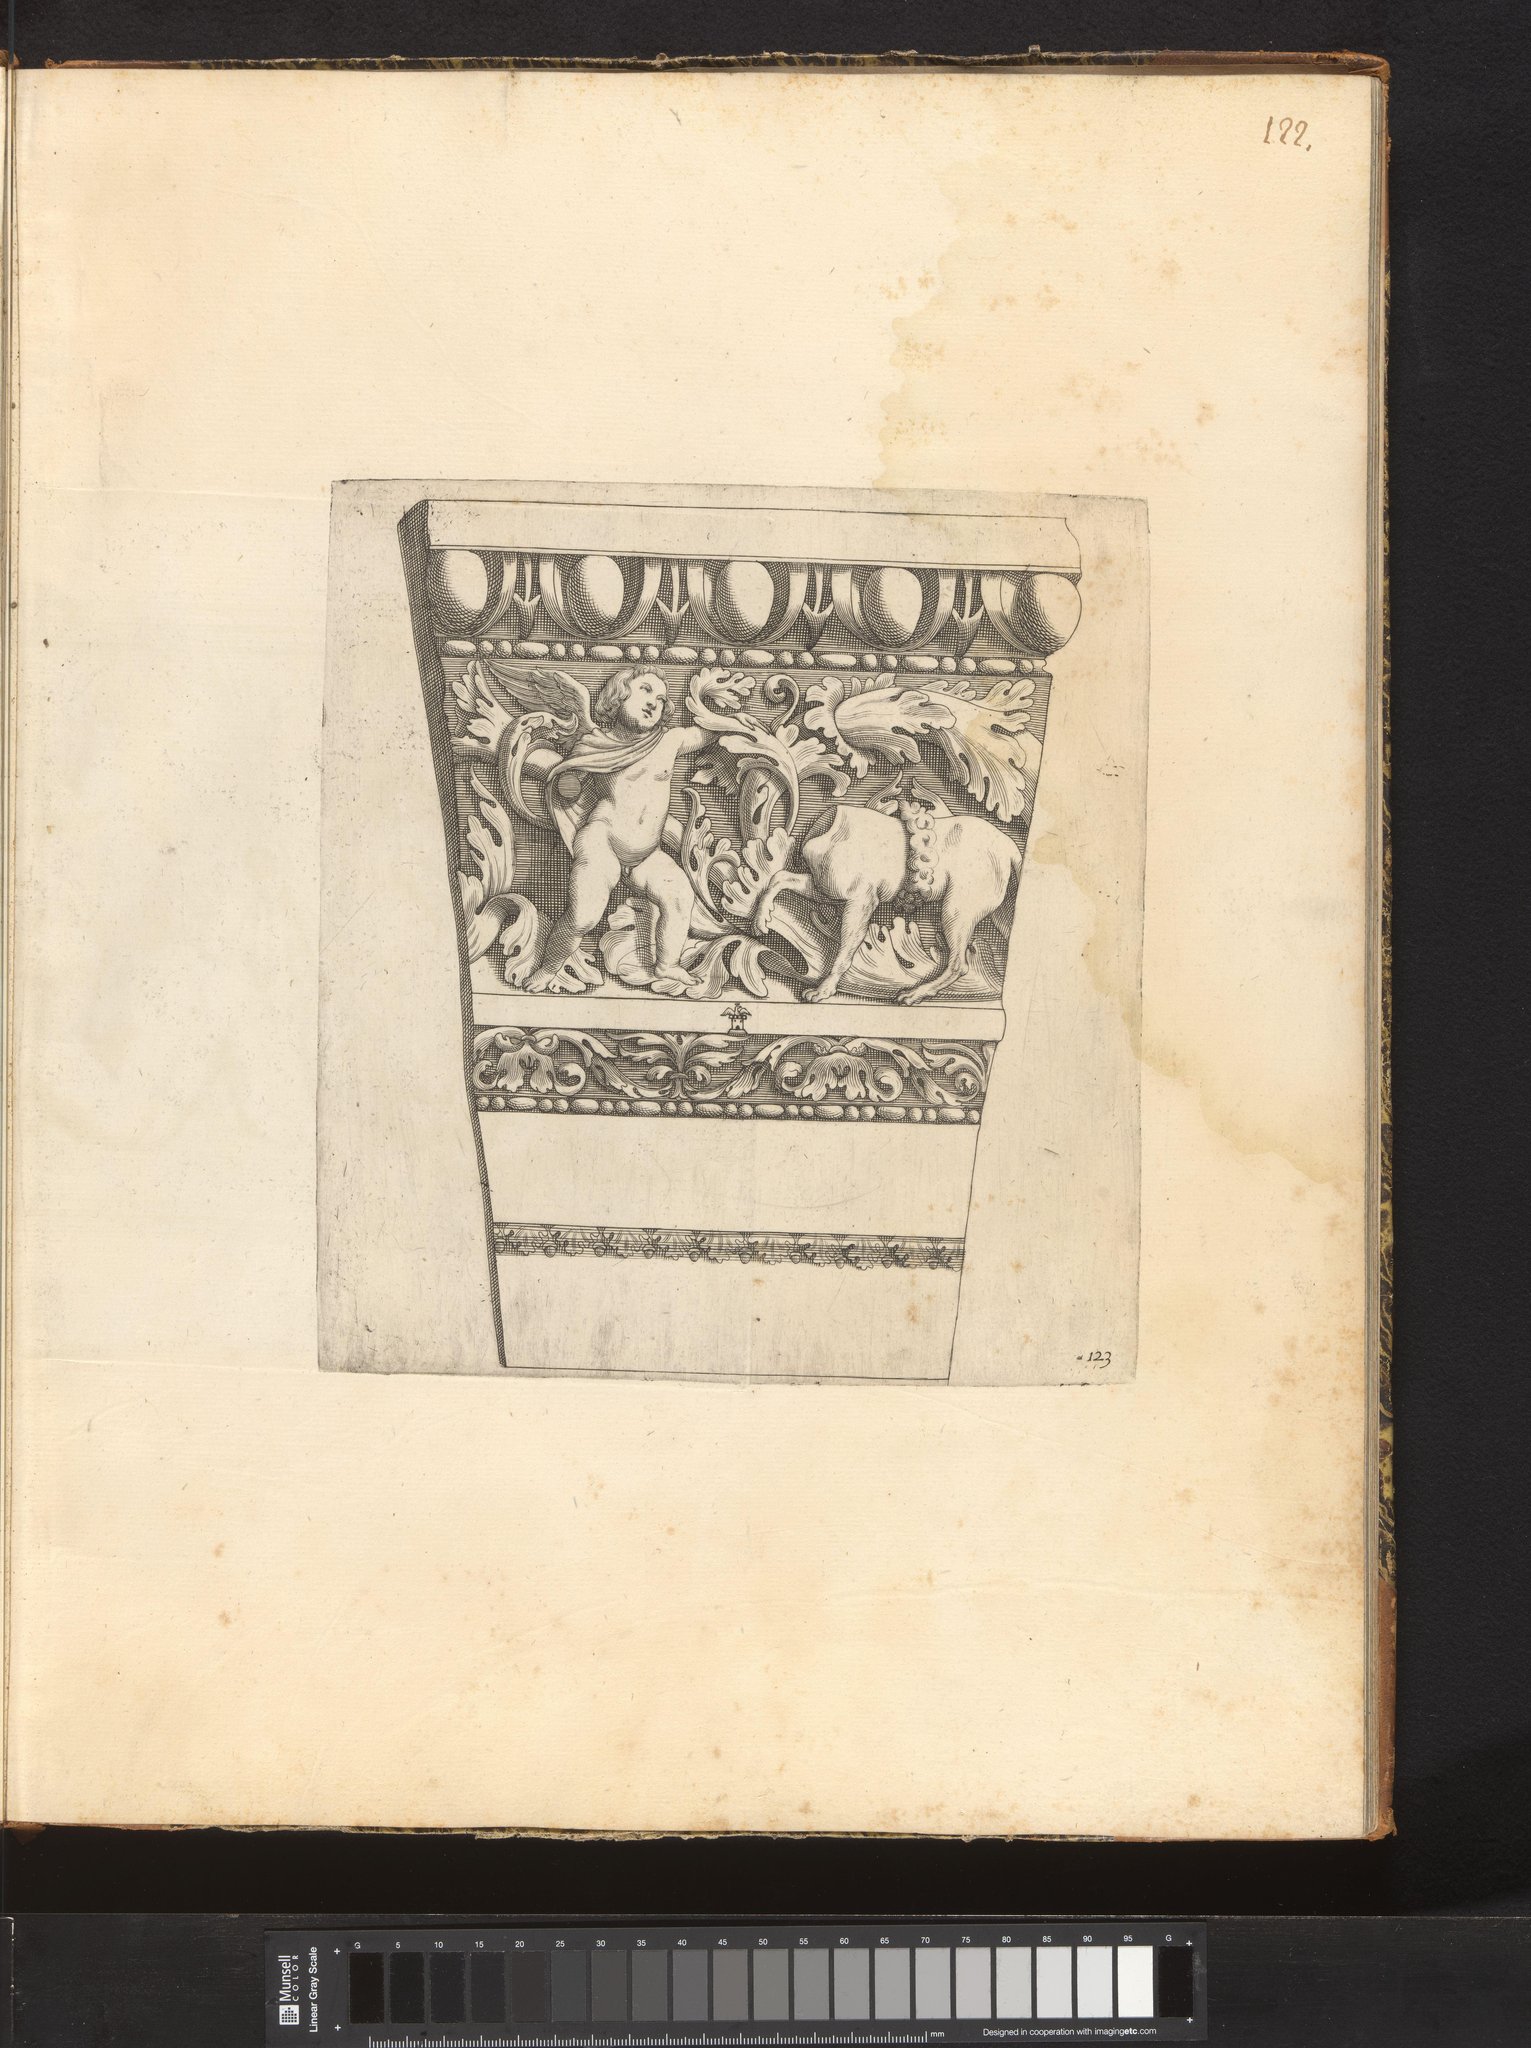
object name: print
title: Galleria Giustiniana del Marchese Vincenzo Giustiniani II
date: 1636-1647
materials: paper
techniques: engraving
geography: rome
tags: (story of) proserpina (persephone, core), libera, column, pillar ~ architecture, (story of) pluto (hades), dis pater, orcus, piece of sculpture, reproduction of a piece of sculpture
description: Romeinse zuilen waarop de geschiedenis van Pluto en Proserpina. Midden onder het wapenschild van Vincenzo Giustiniani. Prent maakt deel uit van een album met een serie prenten naar de sculpturen in de verzameling in de Galleria Giustiniani te Rome.